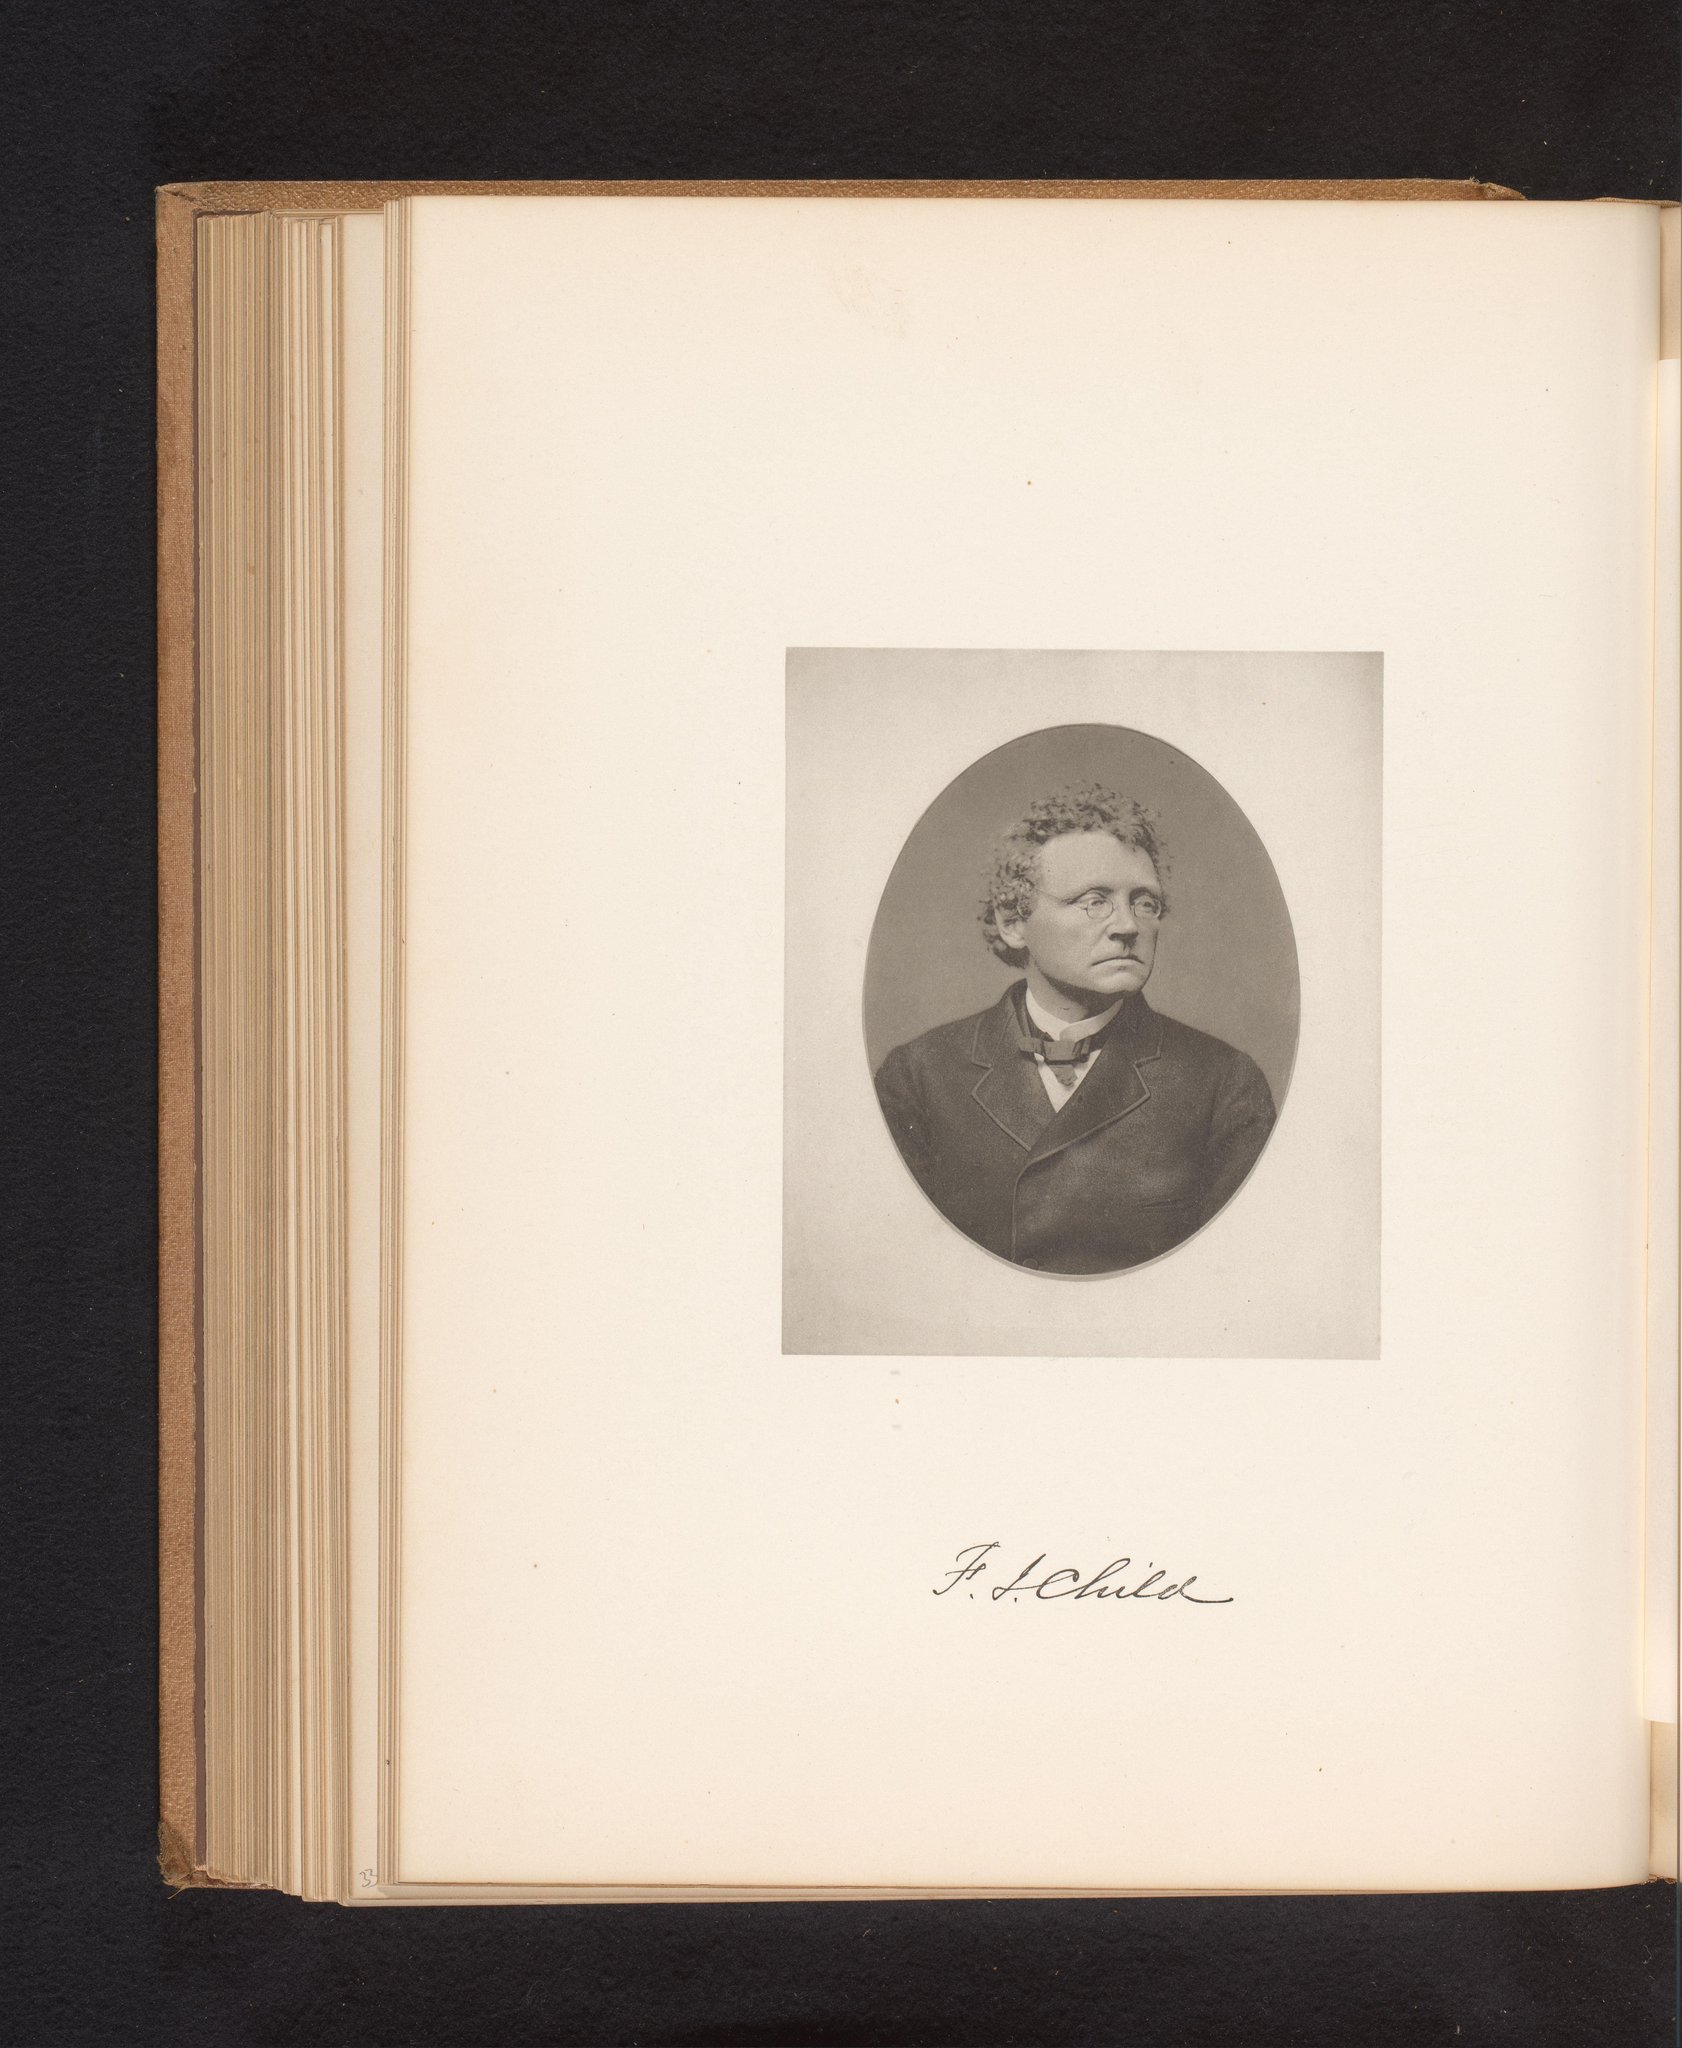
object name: photomechanical print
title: F.J. Child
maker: Anonymous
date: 1870-1875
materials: paper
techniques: photograph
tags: historical persons, professor